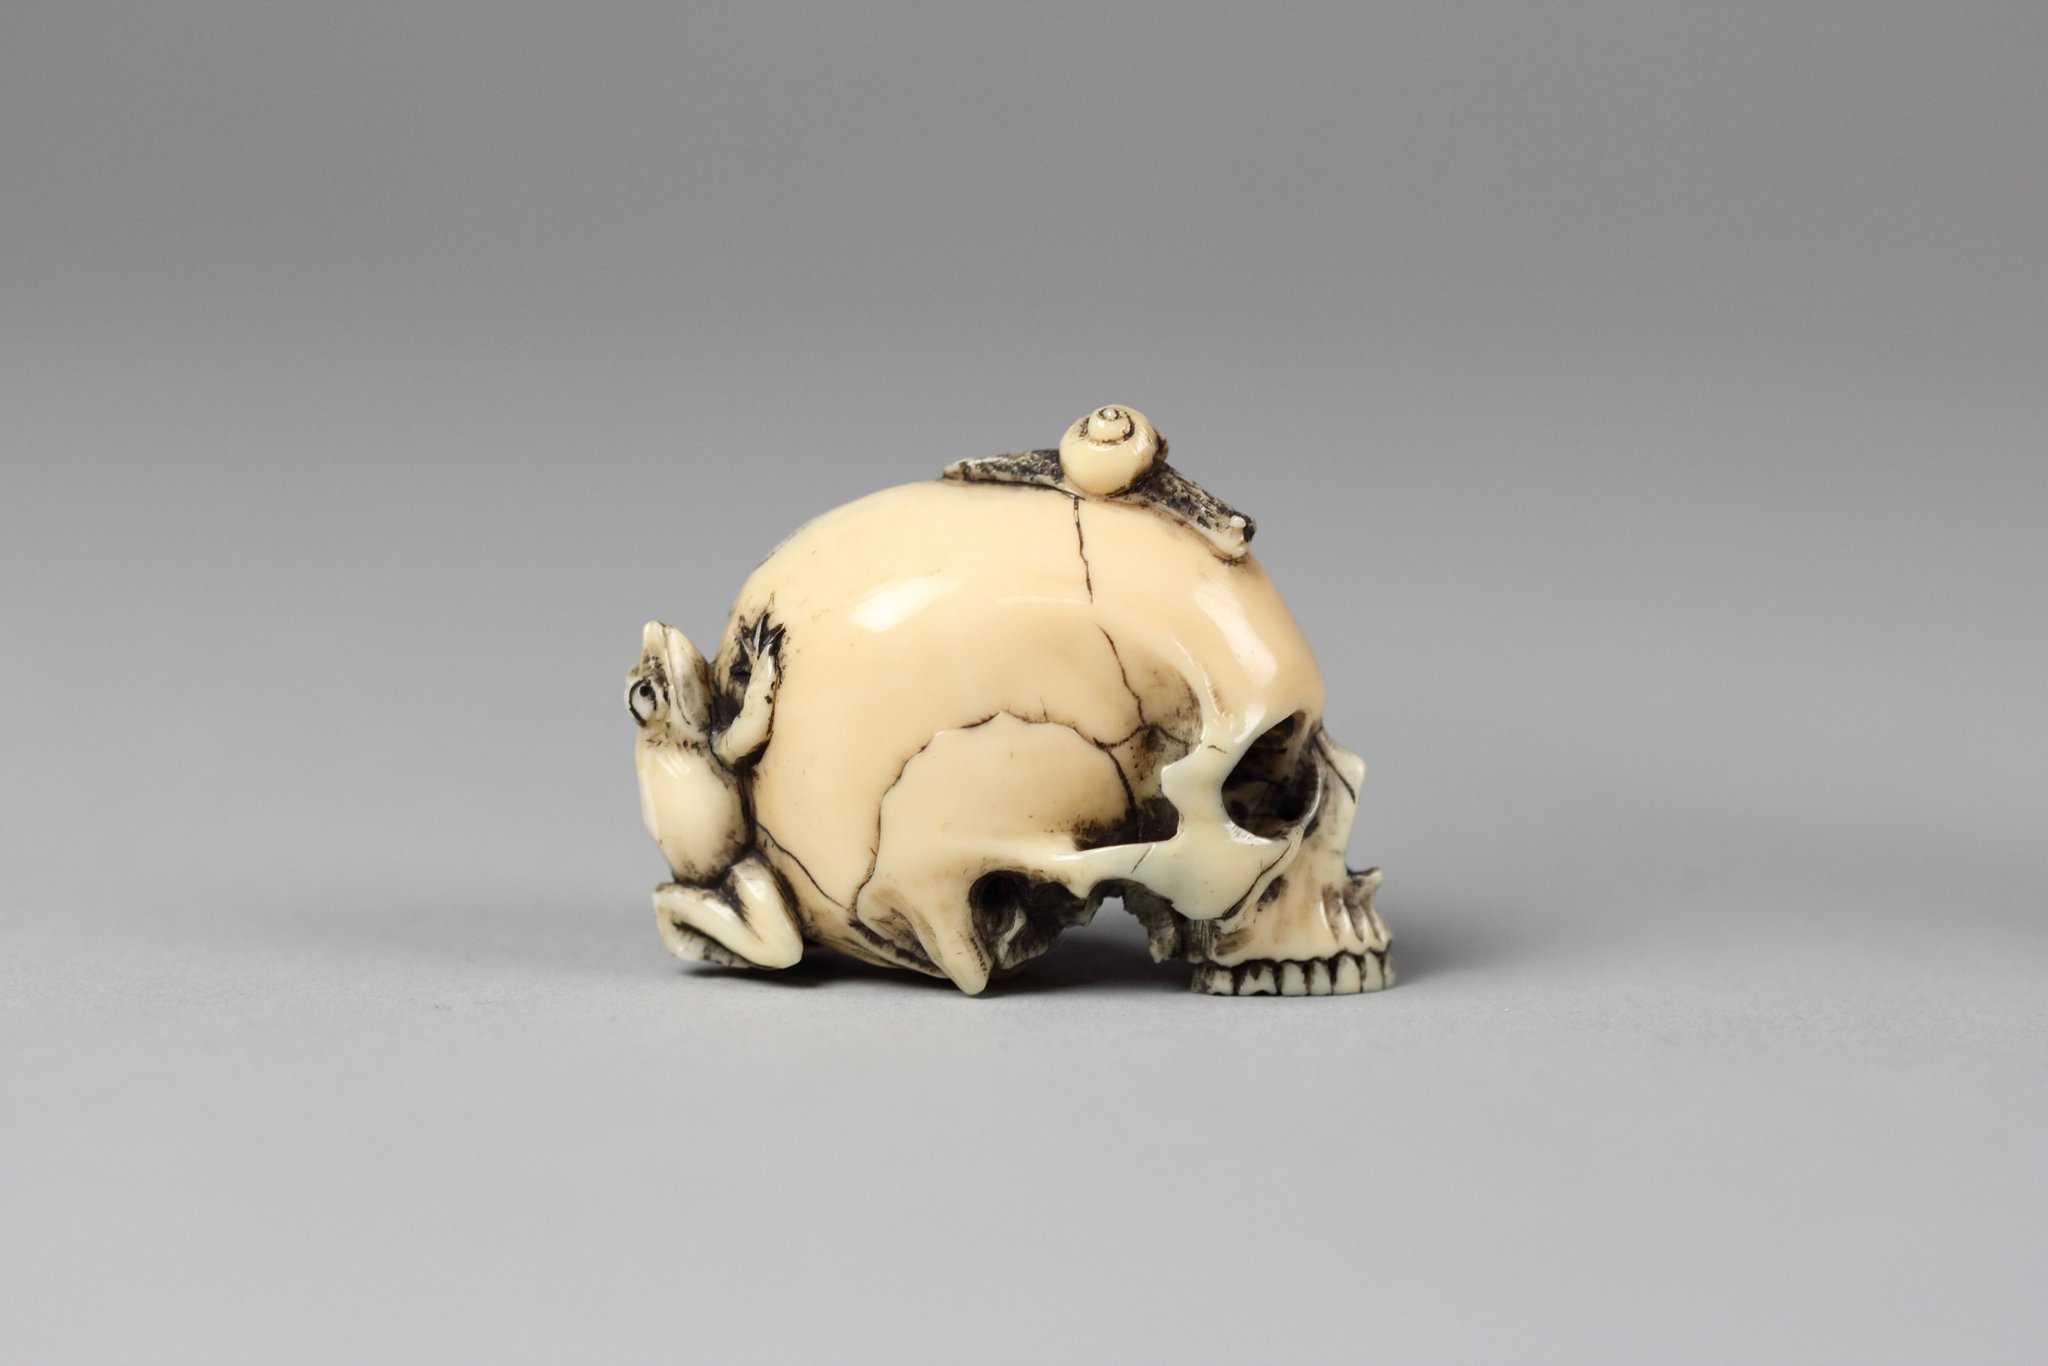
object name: netsuke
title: Netsuke of Skull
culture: japanese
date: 1801-1900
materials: ivory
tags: skulls,snails